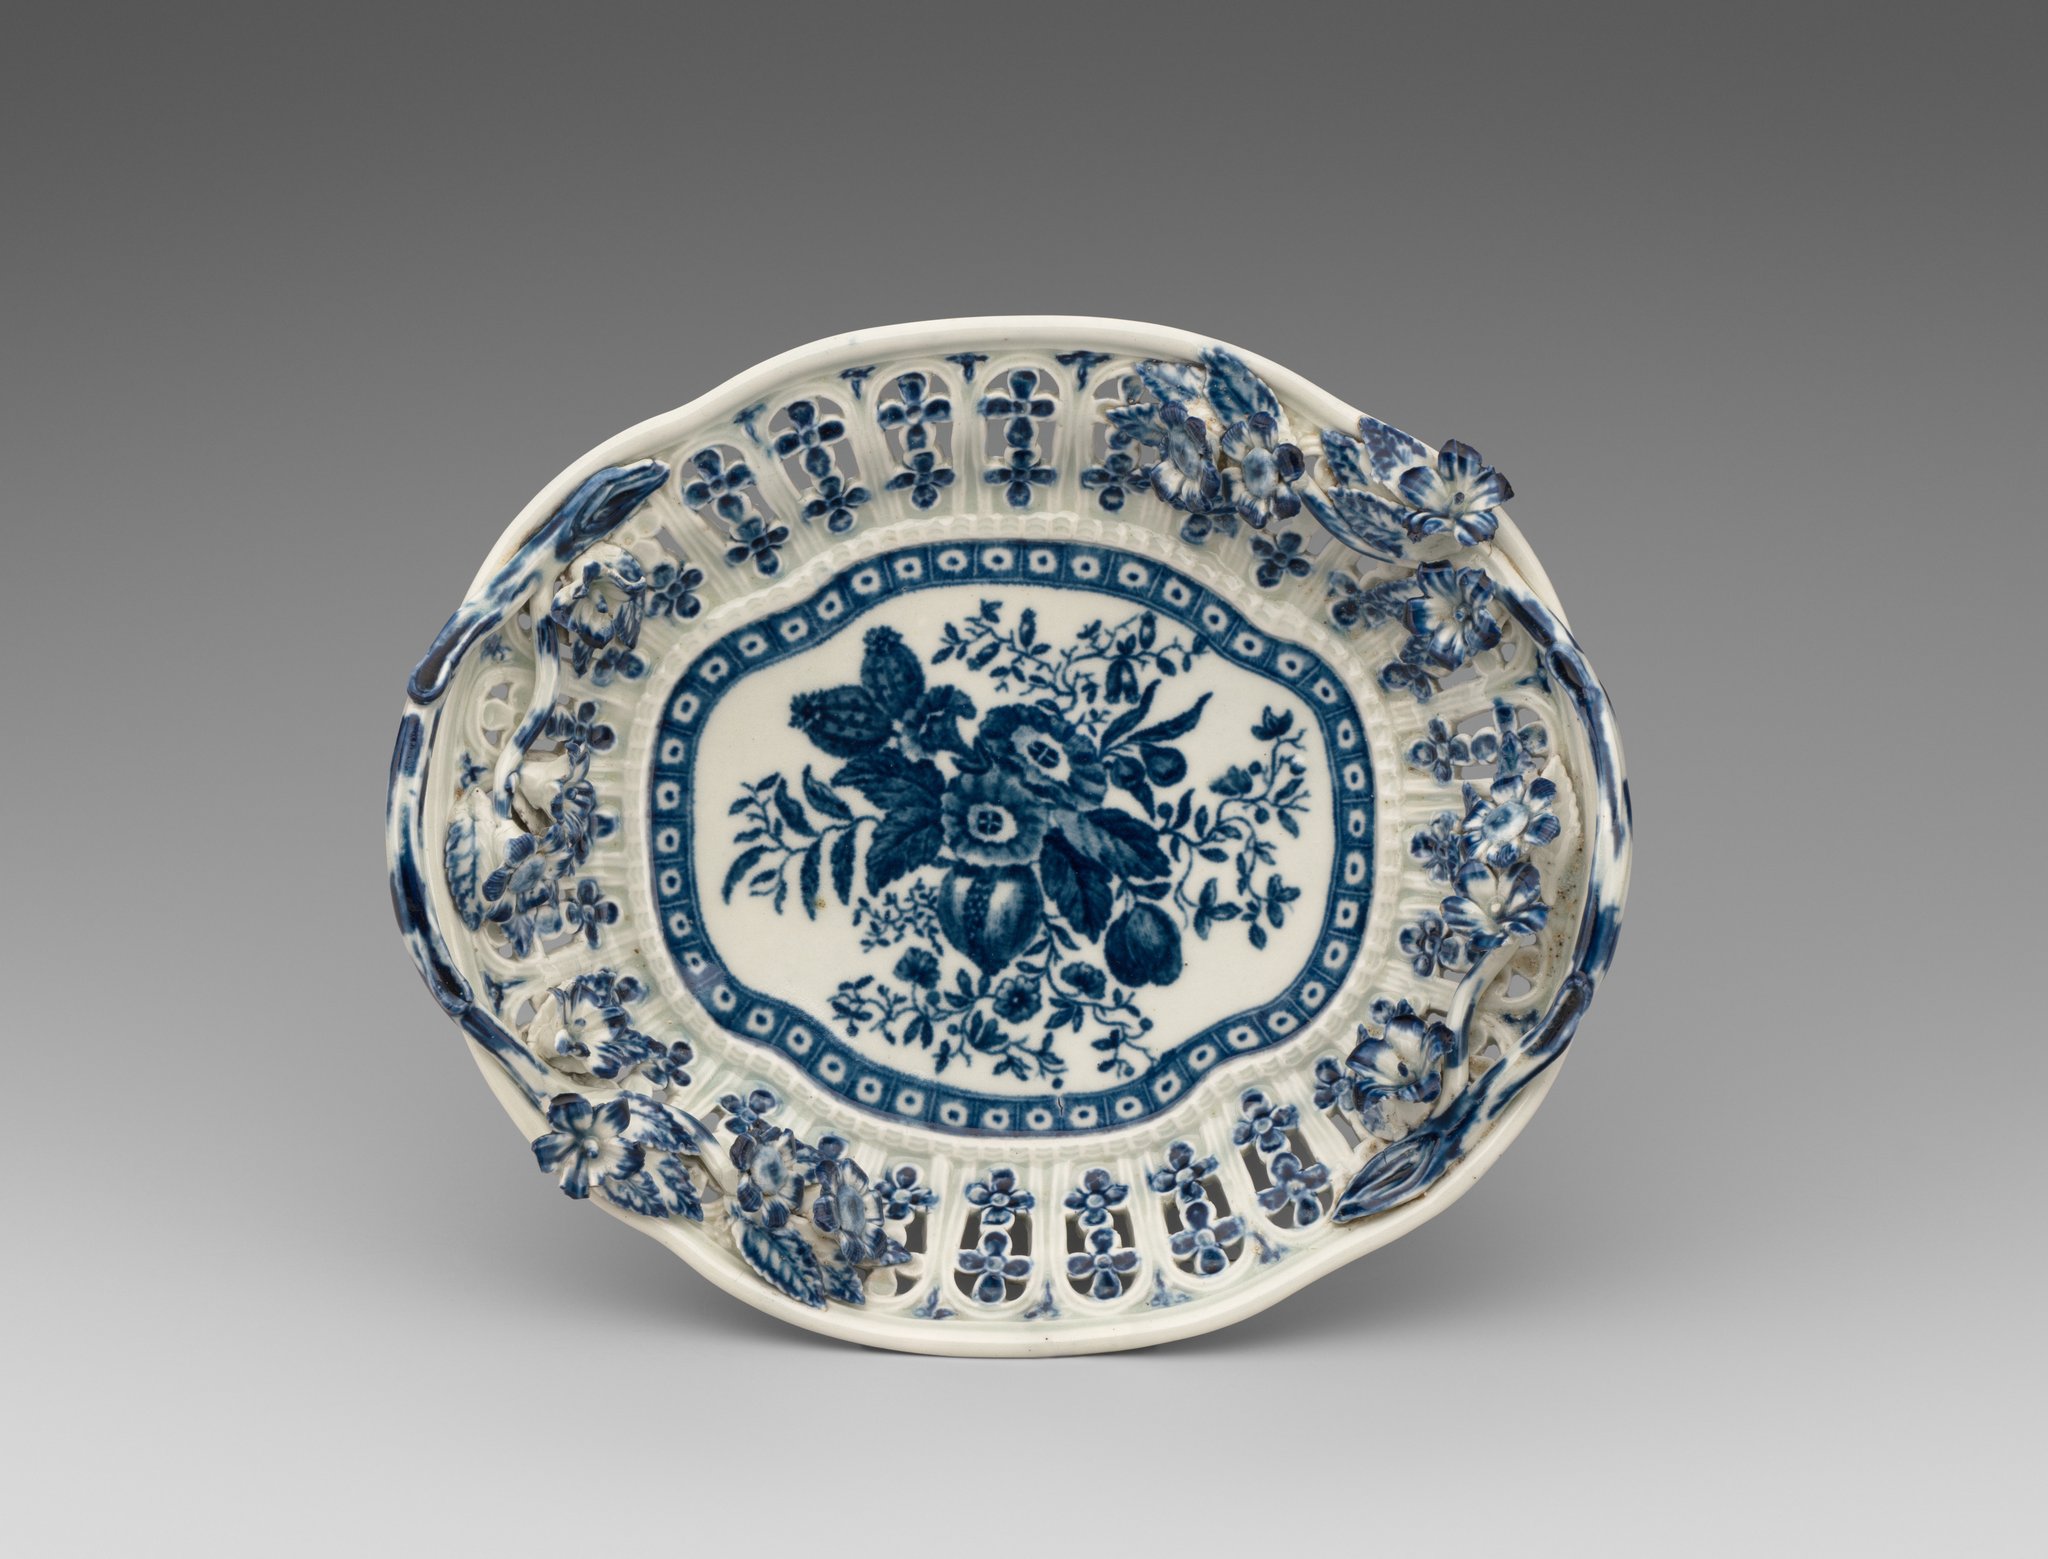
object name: stand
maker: worcester factory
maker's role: factory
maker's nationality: british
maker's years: 1751-2008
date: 1770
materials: soft paste porcelain